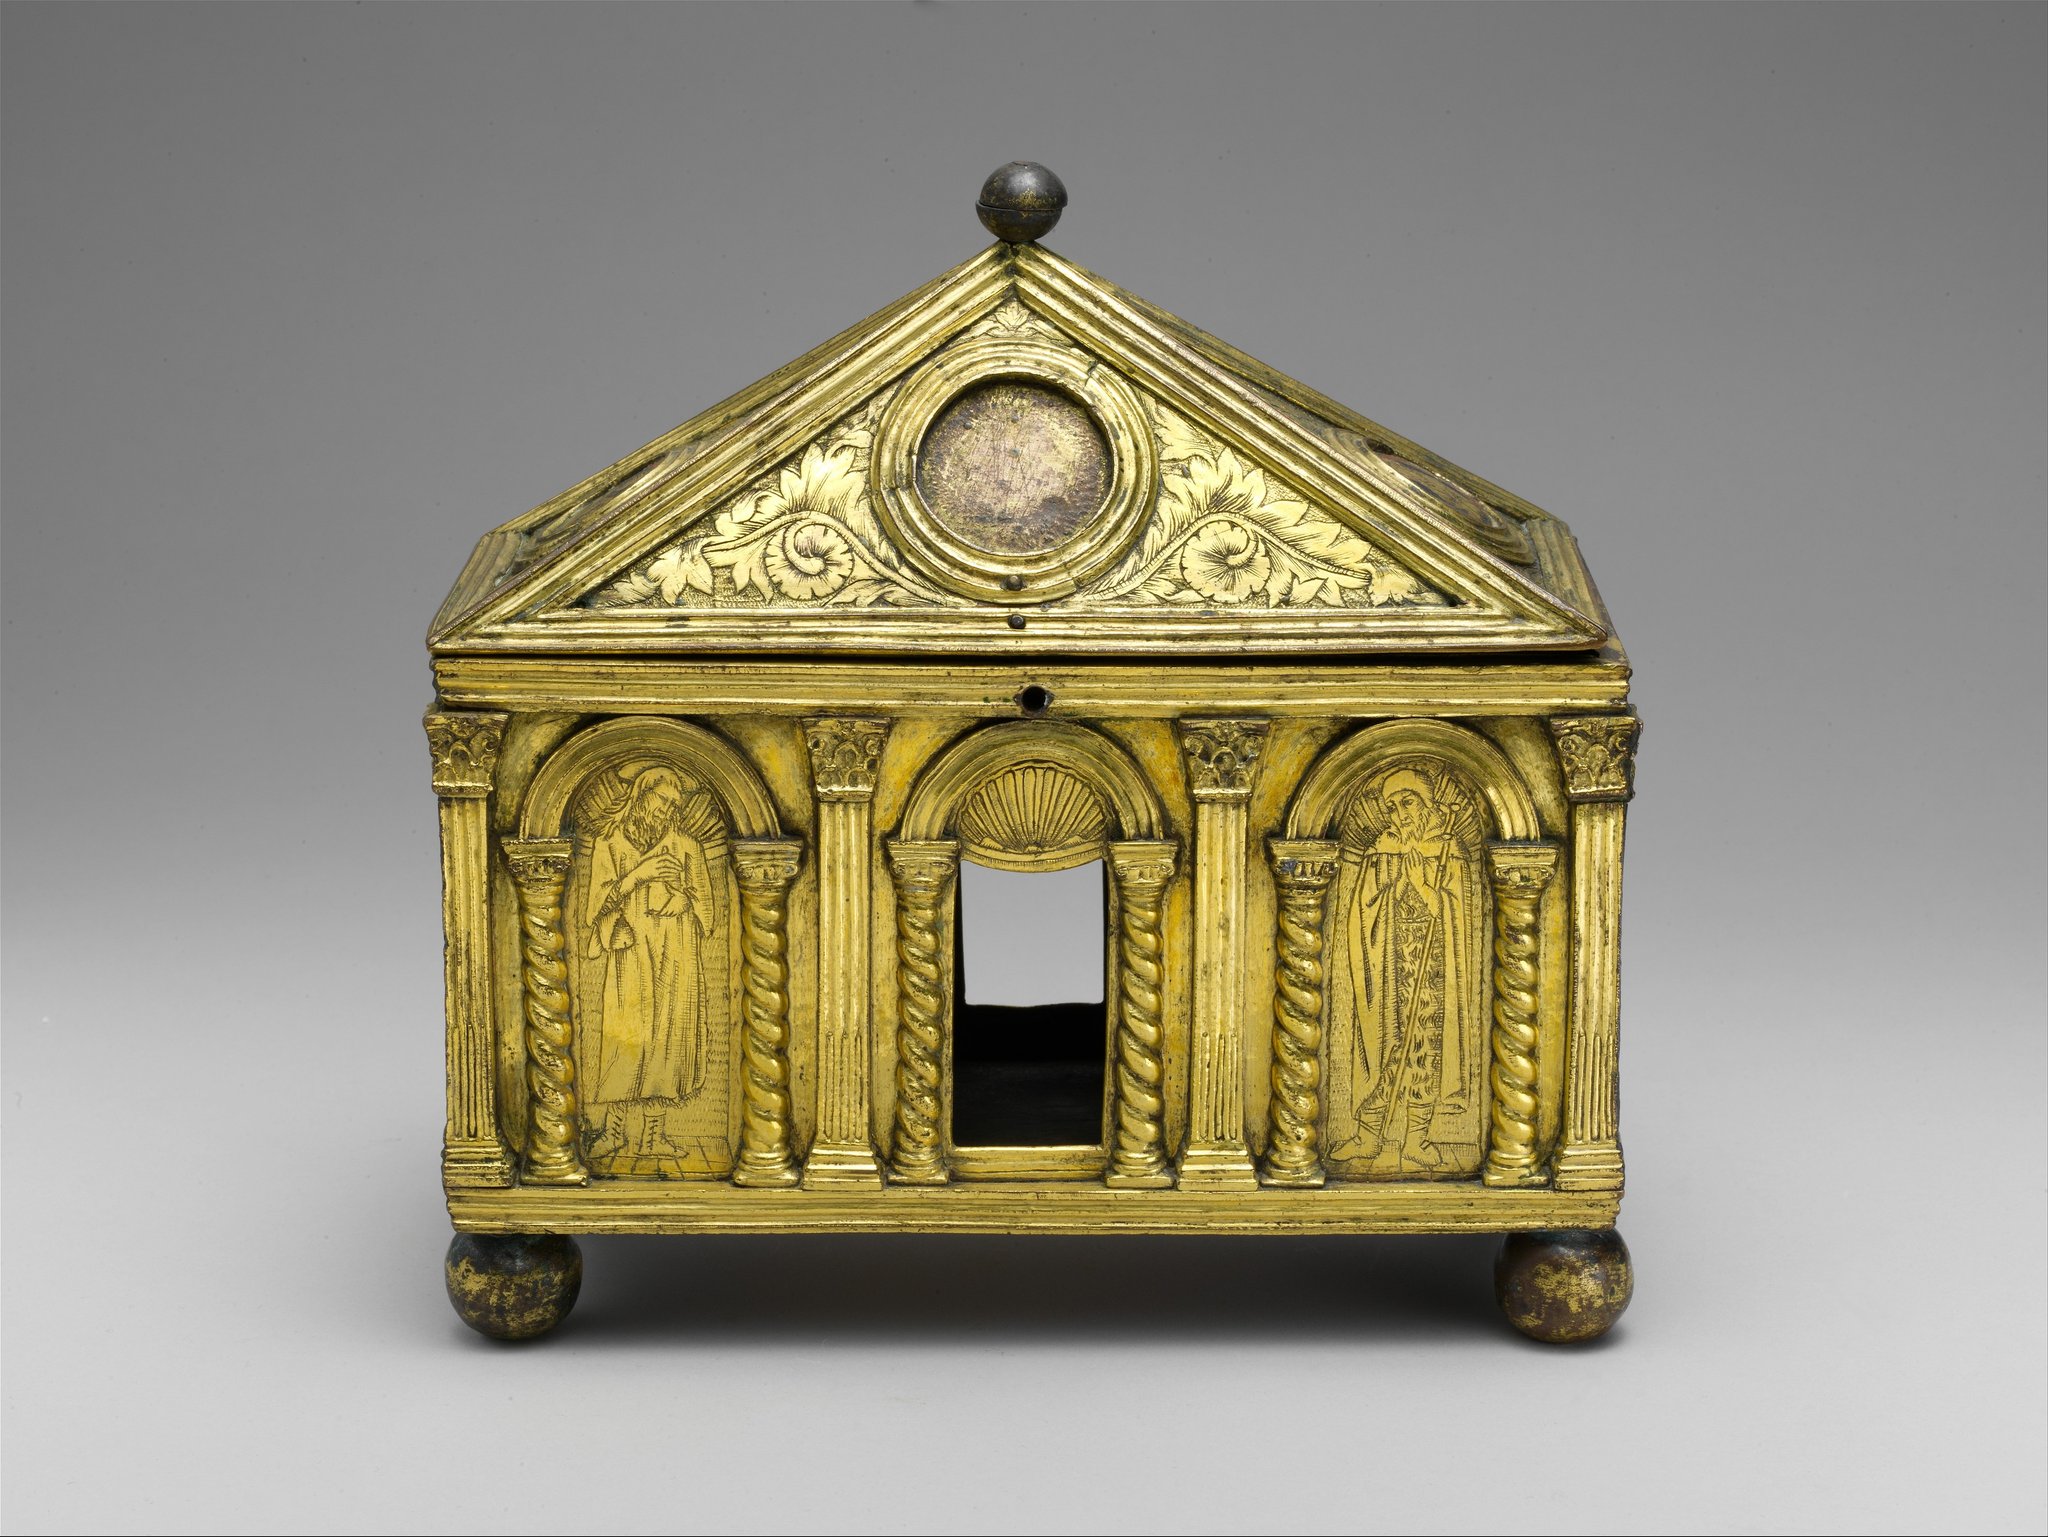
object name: reliquary casket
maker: lorenzo ghiberti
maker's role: artist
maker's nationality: italian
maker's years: 1378-1455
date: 1446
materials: enamel, copper gilt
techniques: enamel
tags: reliquaries